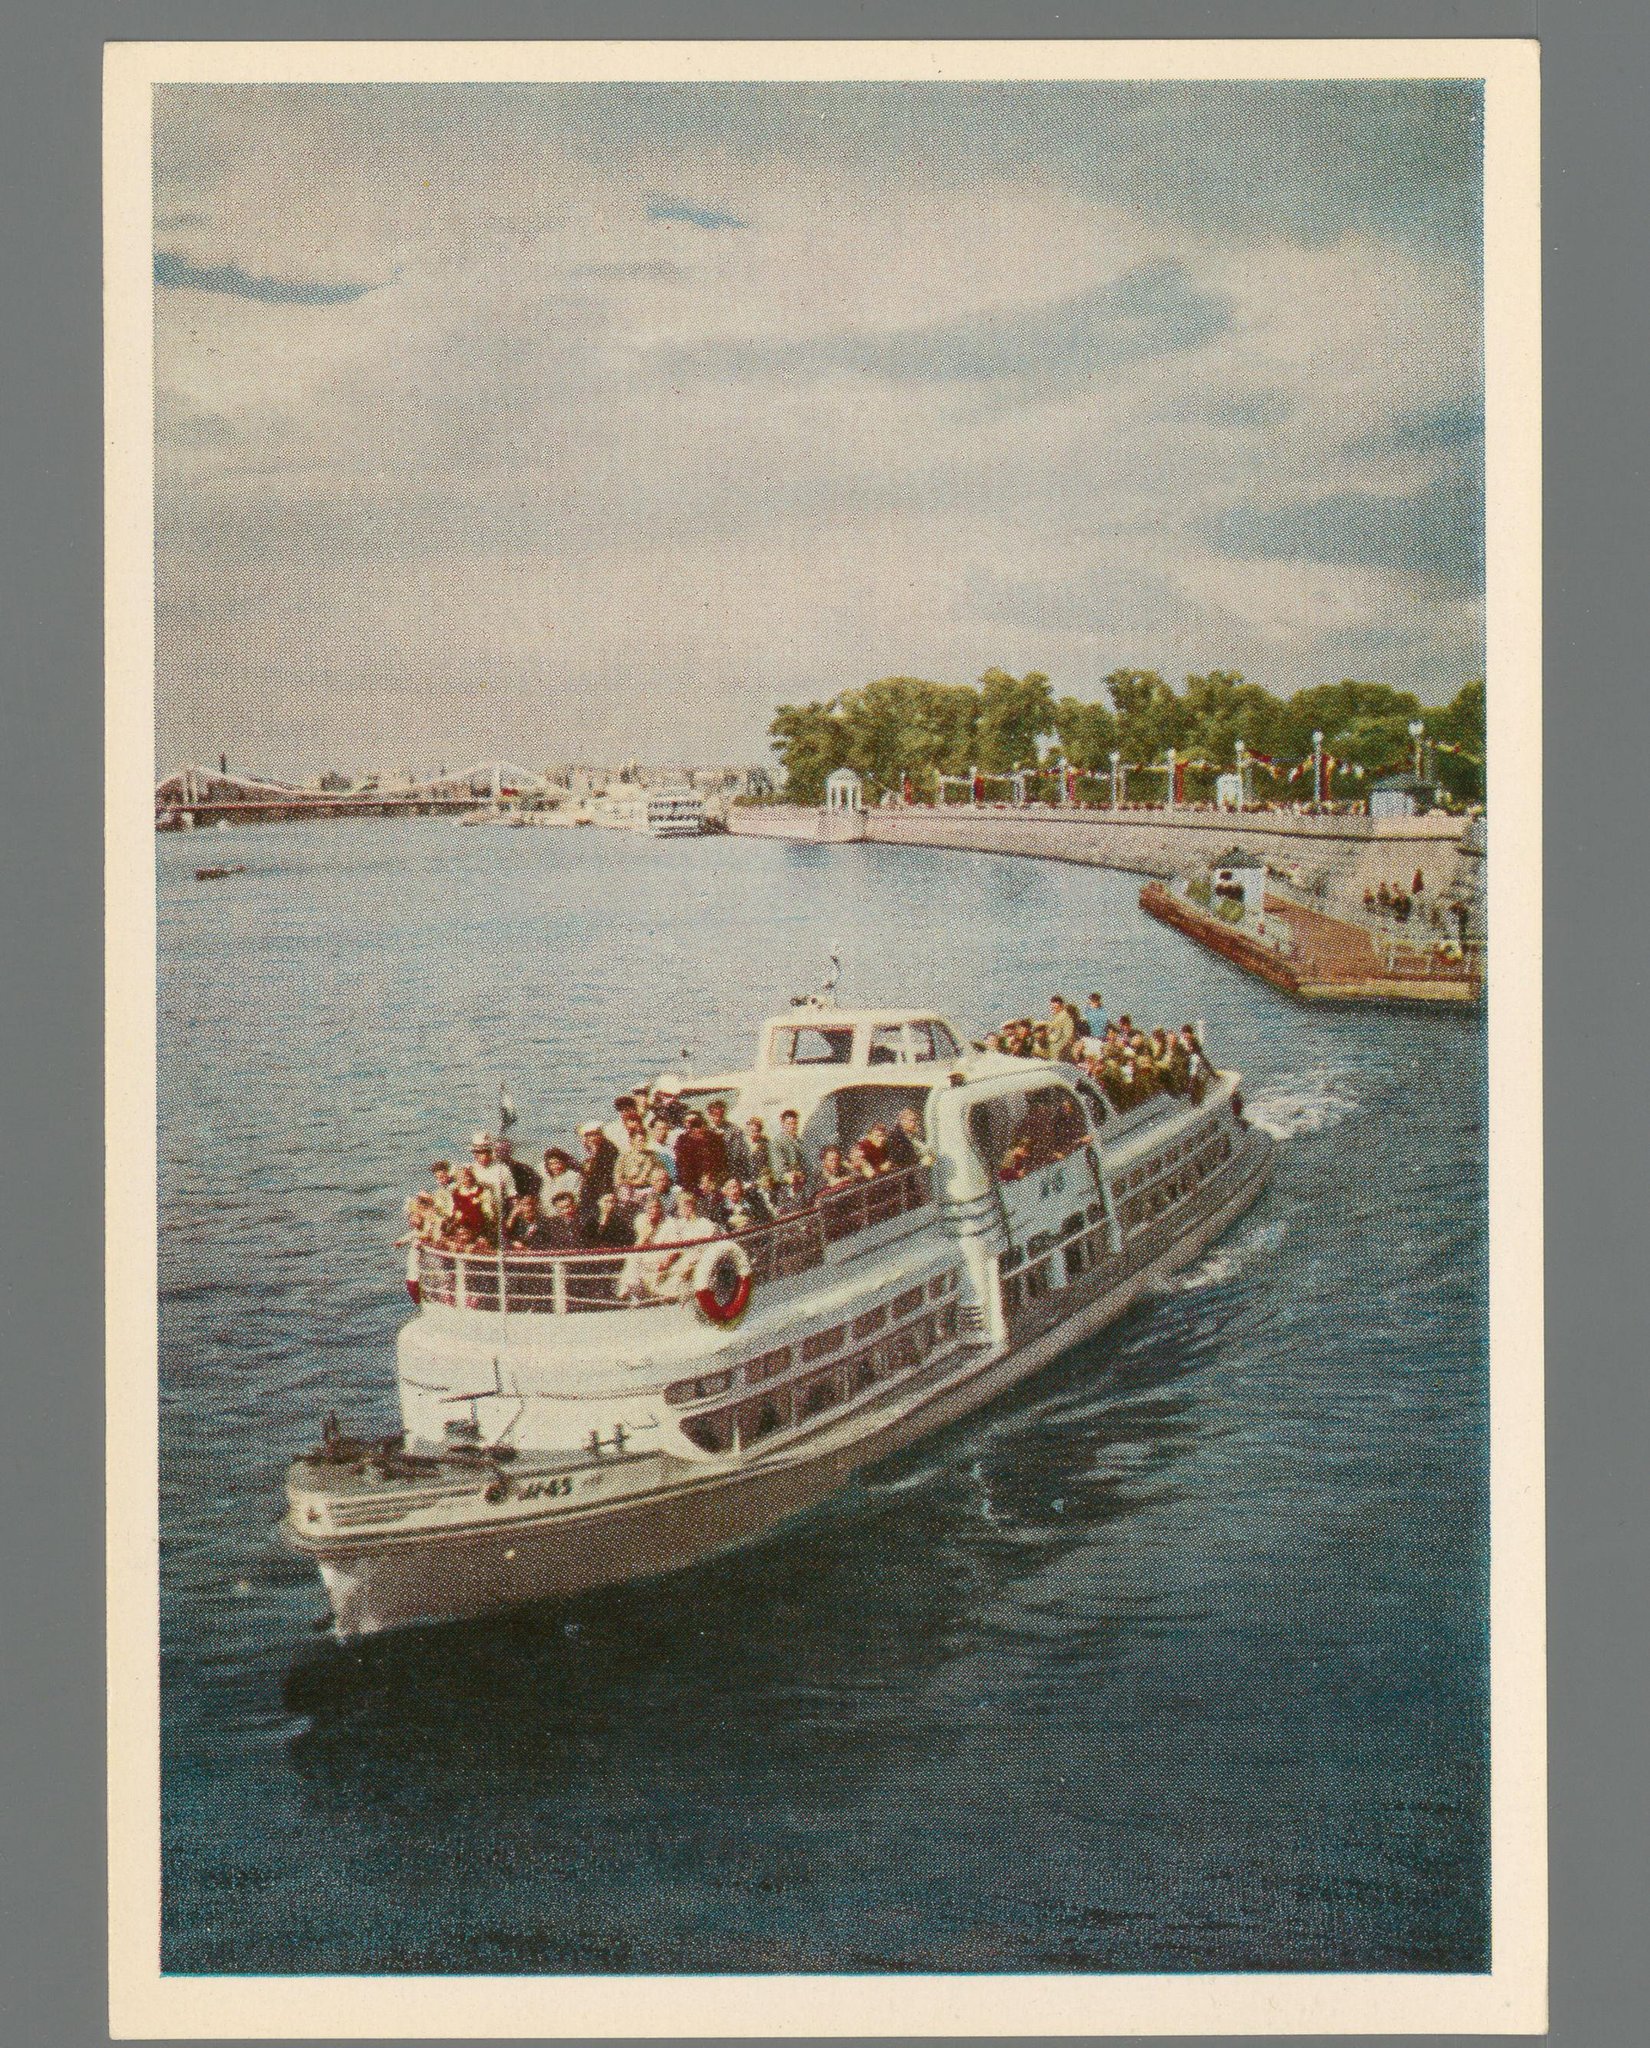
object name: photomechanical print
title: Moscow. Moskva River at the Gorky Central Recreation Park / Moskau. Moskwa-Fluβ beim Zentralen Gorki-Park für Kultur und Erholung / Moscou. La Moskova au Parc de culture et de repos Gorki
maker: Anonymous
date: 1956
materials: cardboard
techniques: color autotype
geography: moscow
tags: park, canals, waters (in city)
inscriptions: date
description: De titel op object staat ook in het Russisch.